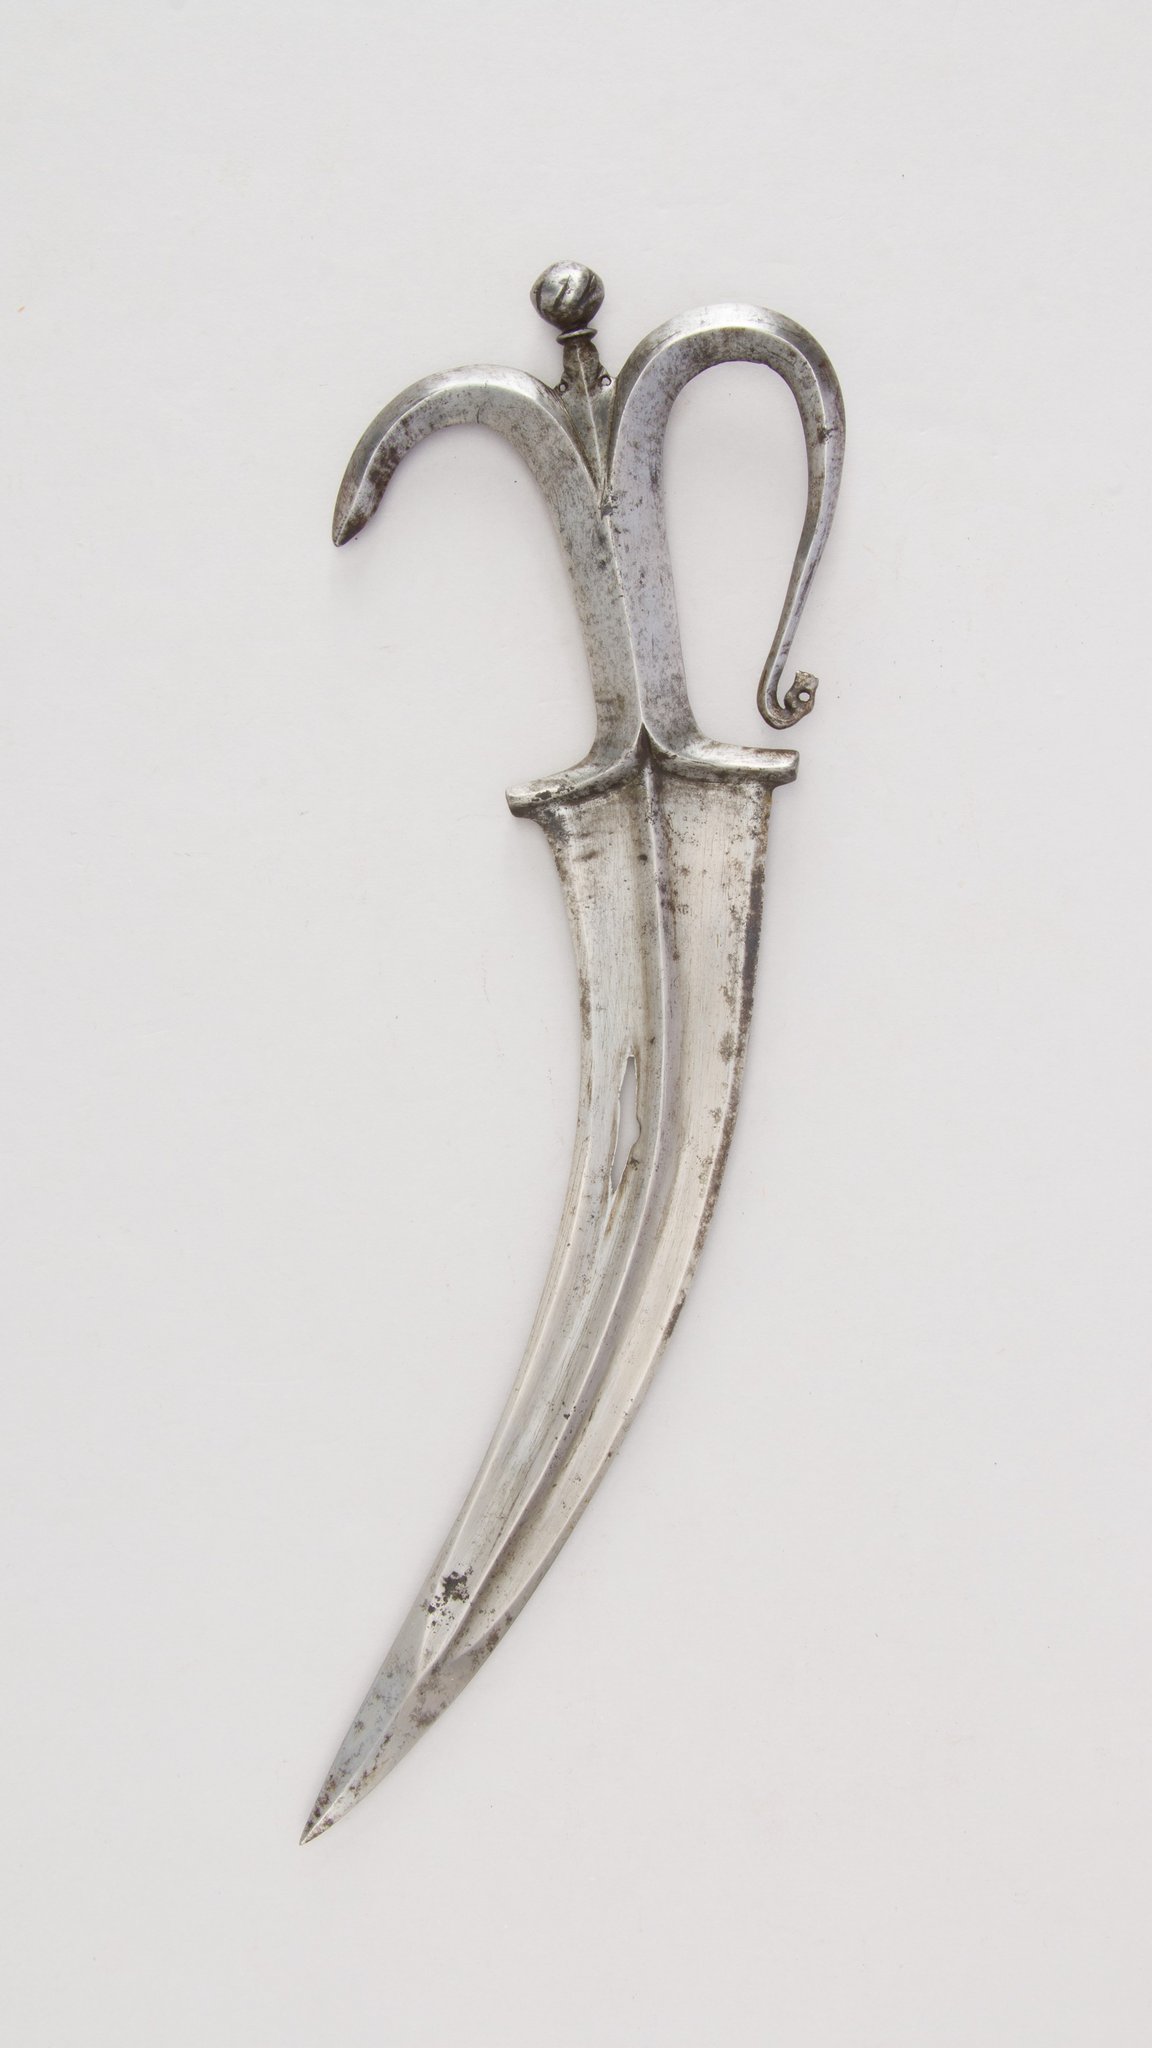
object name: dagger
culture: indian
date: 1501-1700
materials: steel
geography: india